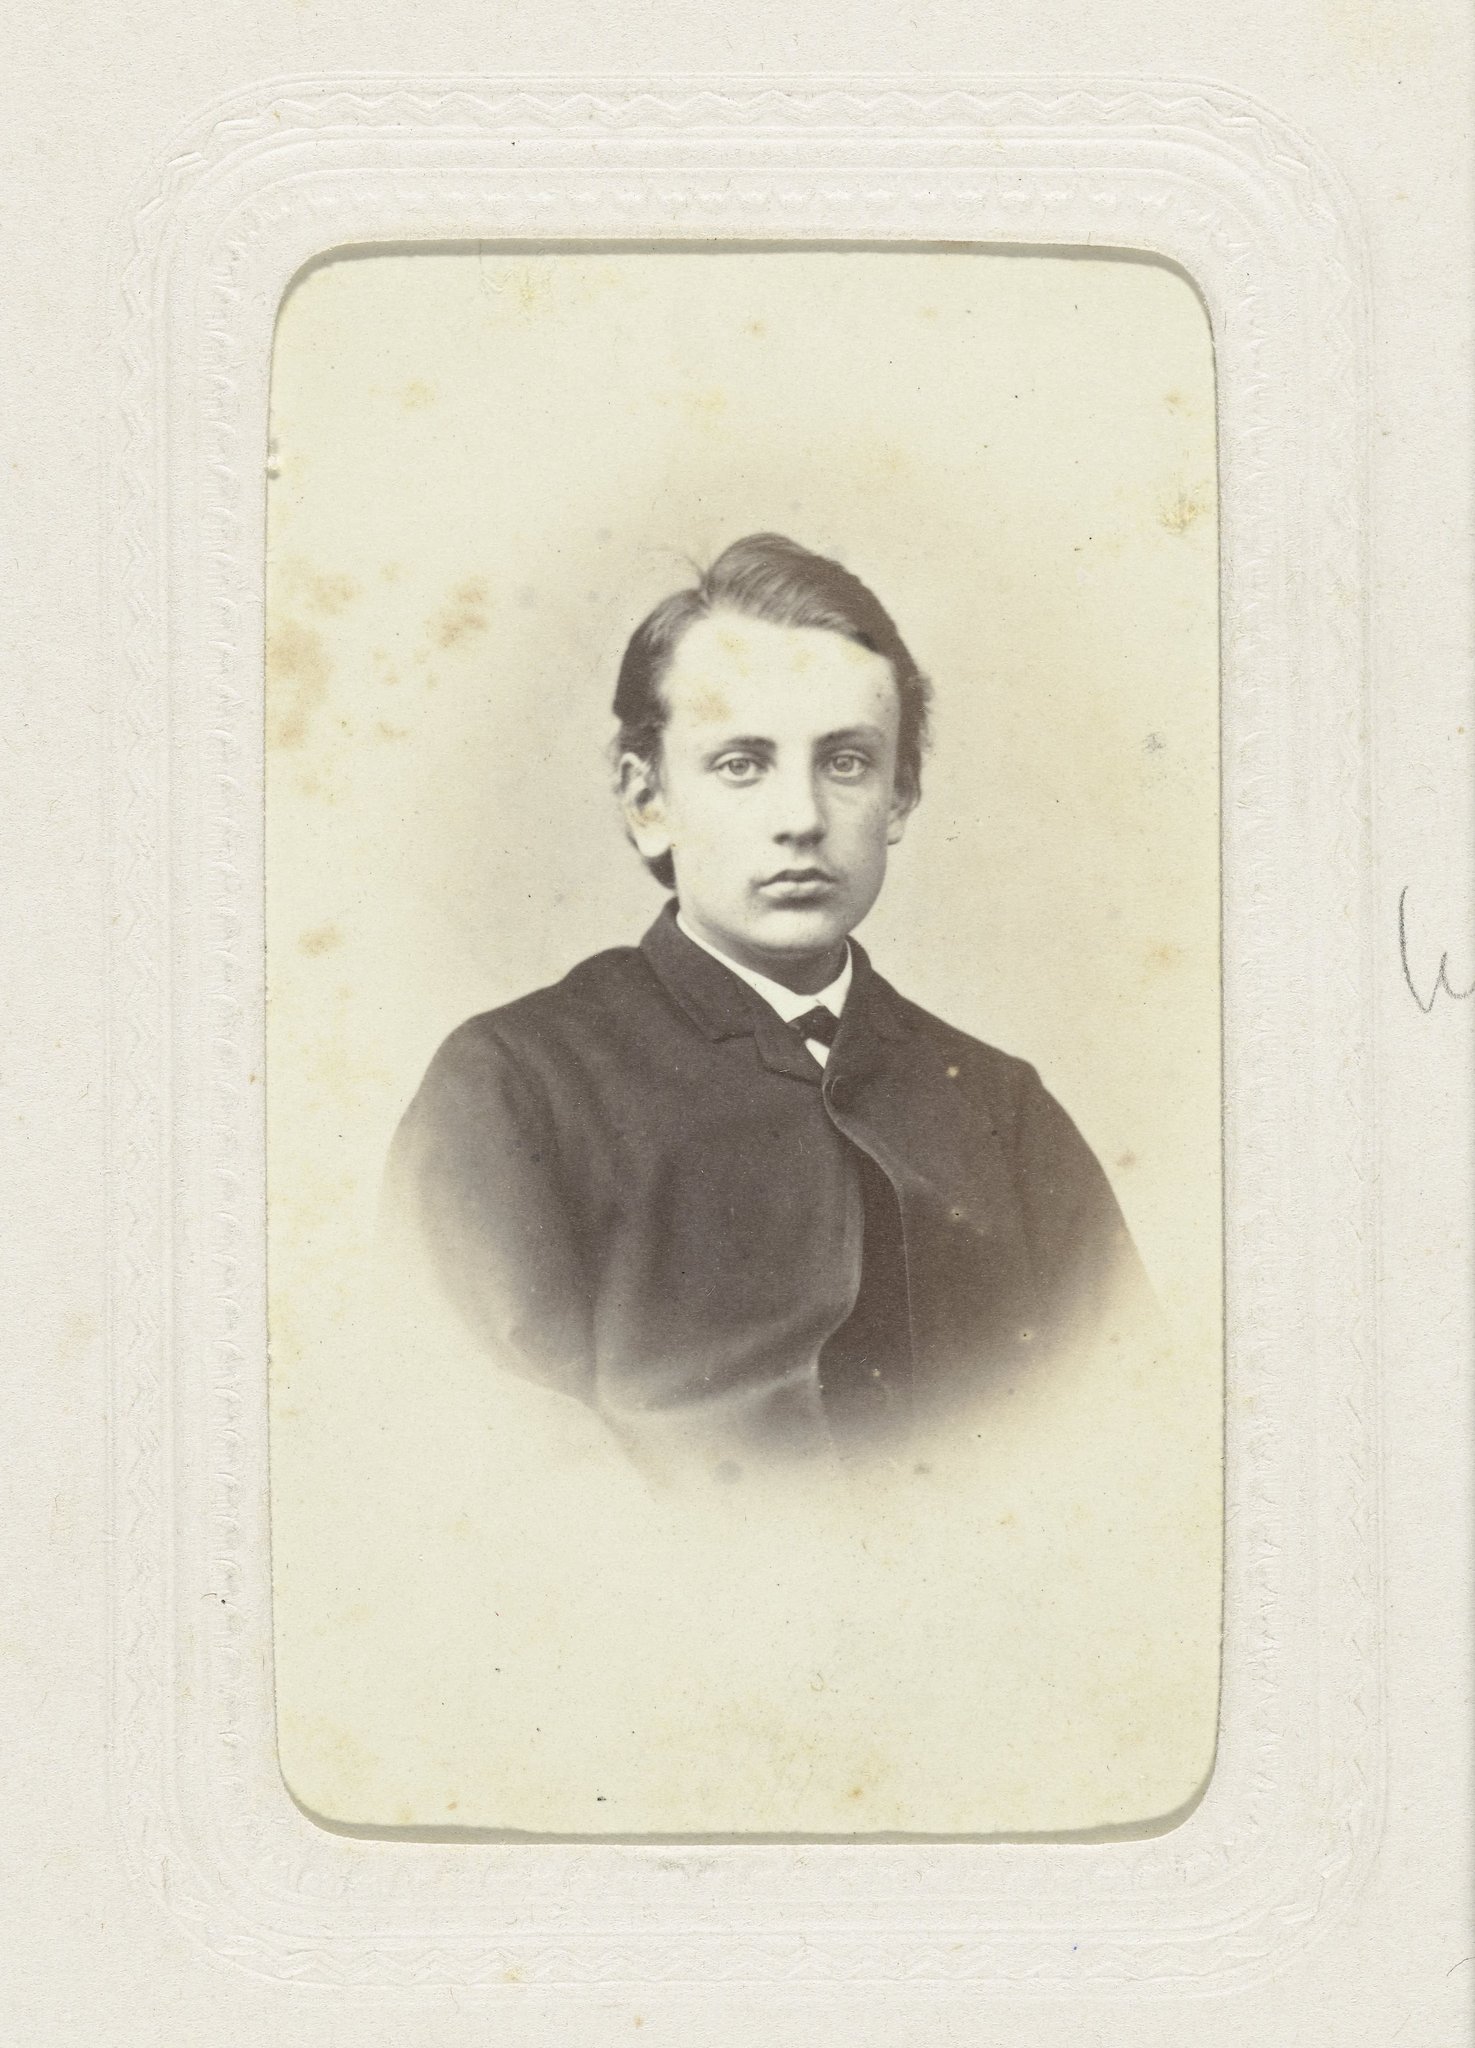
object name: carte de visite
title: Studioportret van een jongen met een strakke scheiding in zijn haar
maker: anthony cornelis weyer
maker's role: fotograaf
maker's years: 1838-1887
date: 1863-1866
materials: cardboard, paper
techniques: albumen print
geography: leiden